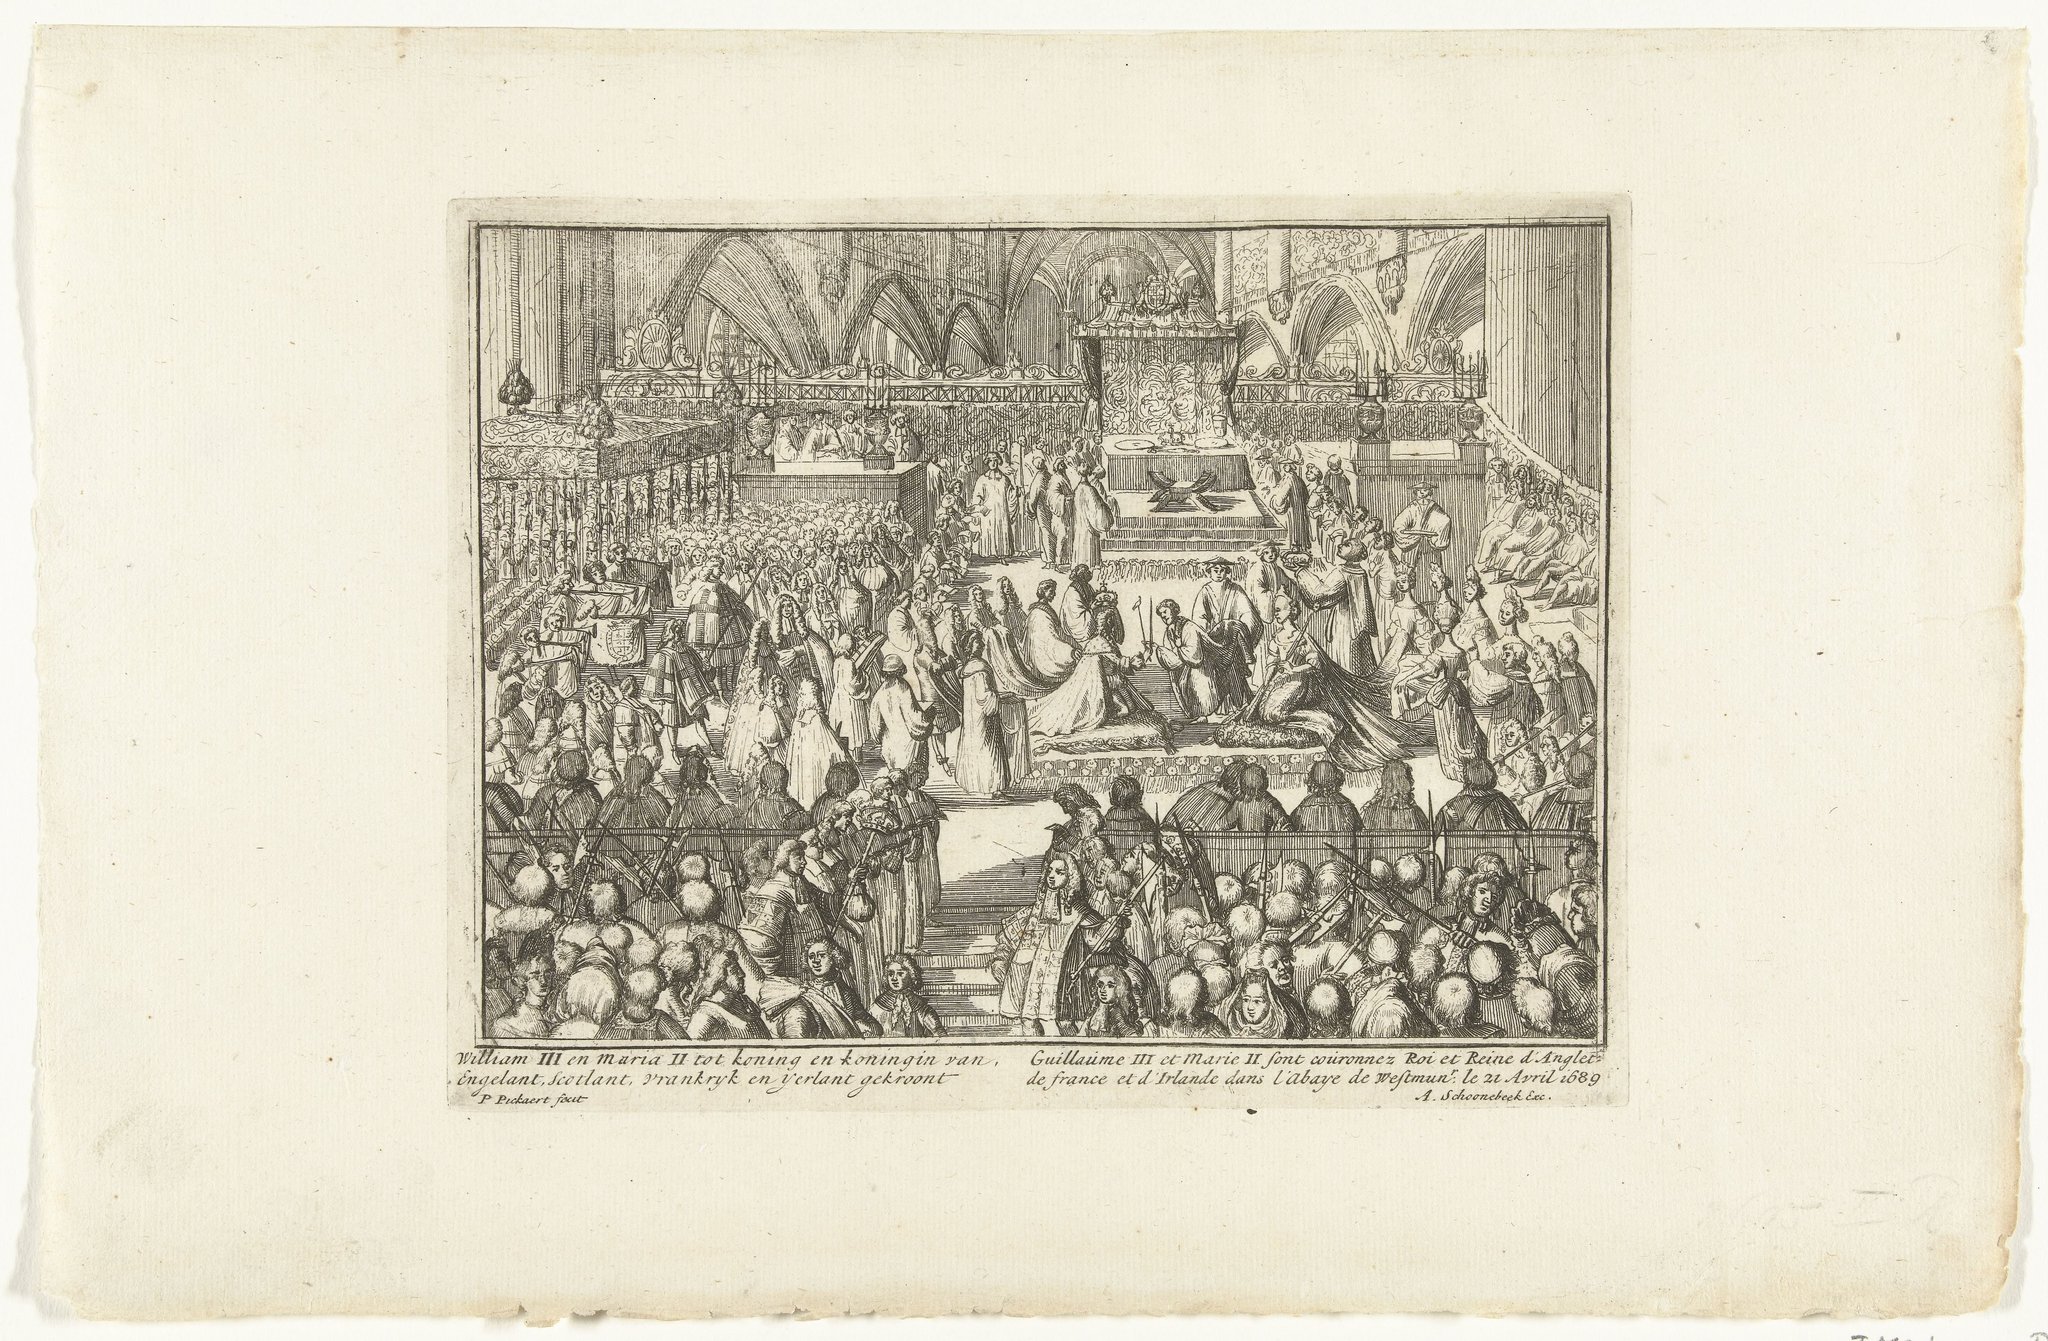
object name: print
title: Kroning van Willem III en Maria, 1689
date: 1689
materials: paper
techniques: etching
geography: amsterdam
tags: the hague, william iii (prince of orange and king of england, scotland, and ireland), london, maria ii stuart (koningin van engeland, schotland en ierland), during the coronation, westminster abbey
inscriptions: collector's mark: Lugt 2760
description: Kroning van prins Willem III en prinses Maria Stuart tot koning en koningin van Engeland, in Westminster Abbey op 21 april 1689. Onderdeel van de serie 'Engelants schouwtoneel' over de Glorious Revolution 1688-1689 (tweede deel). Met onderschriften in het Nederlands en Frans.